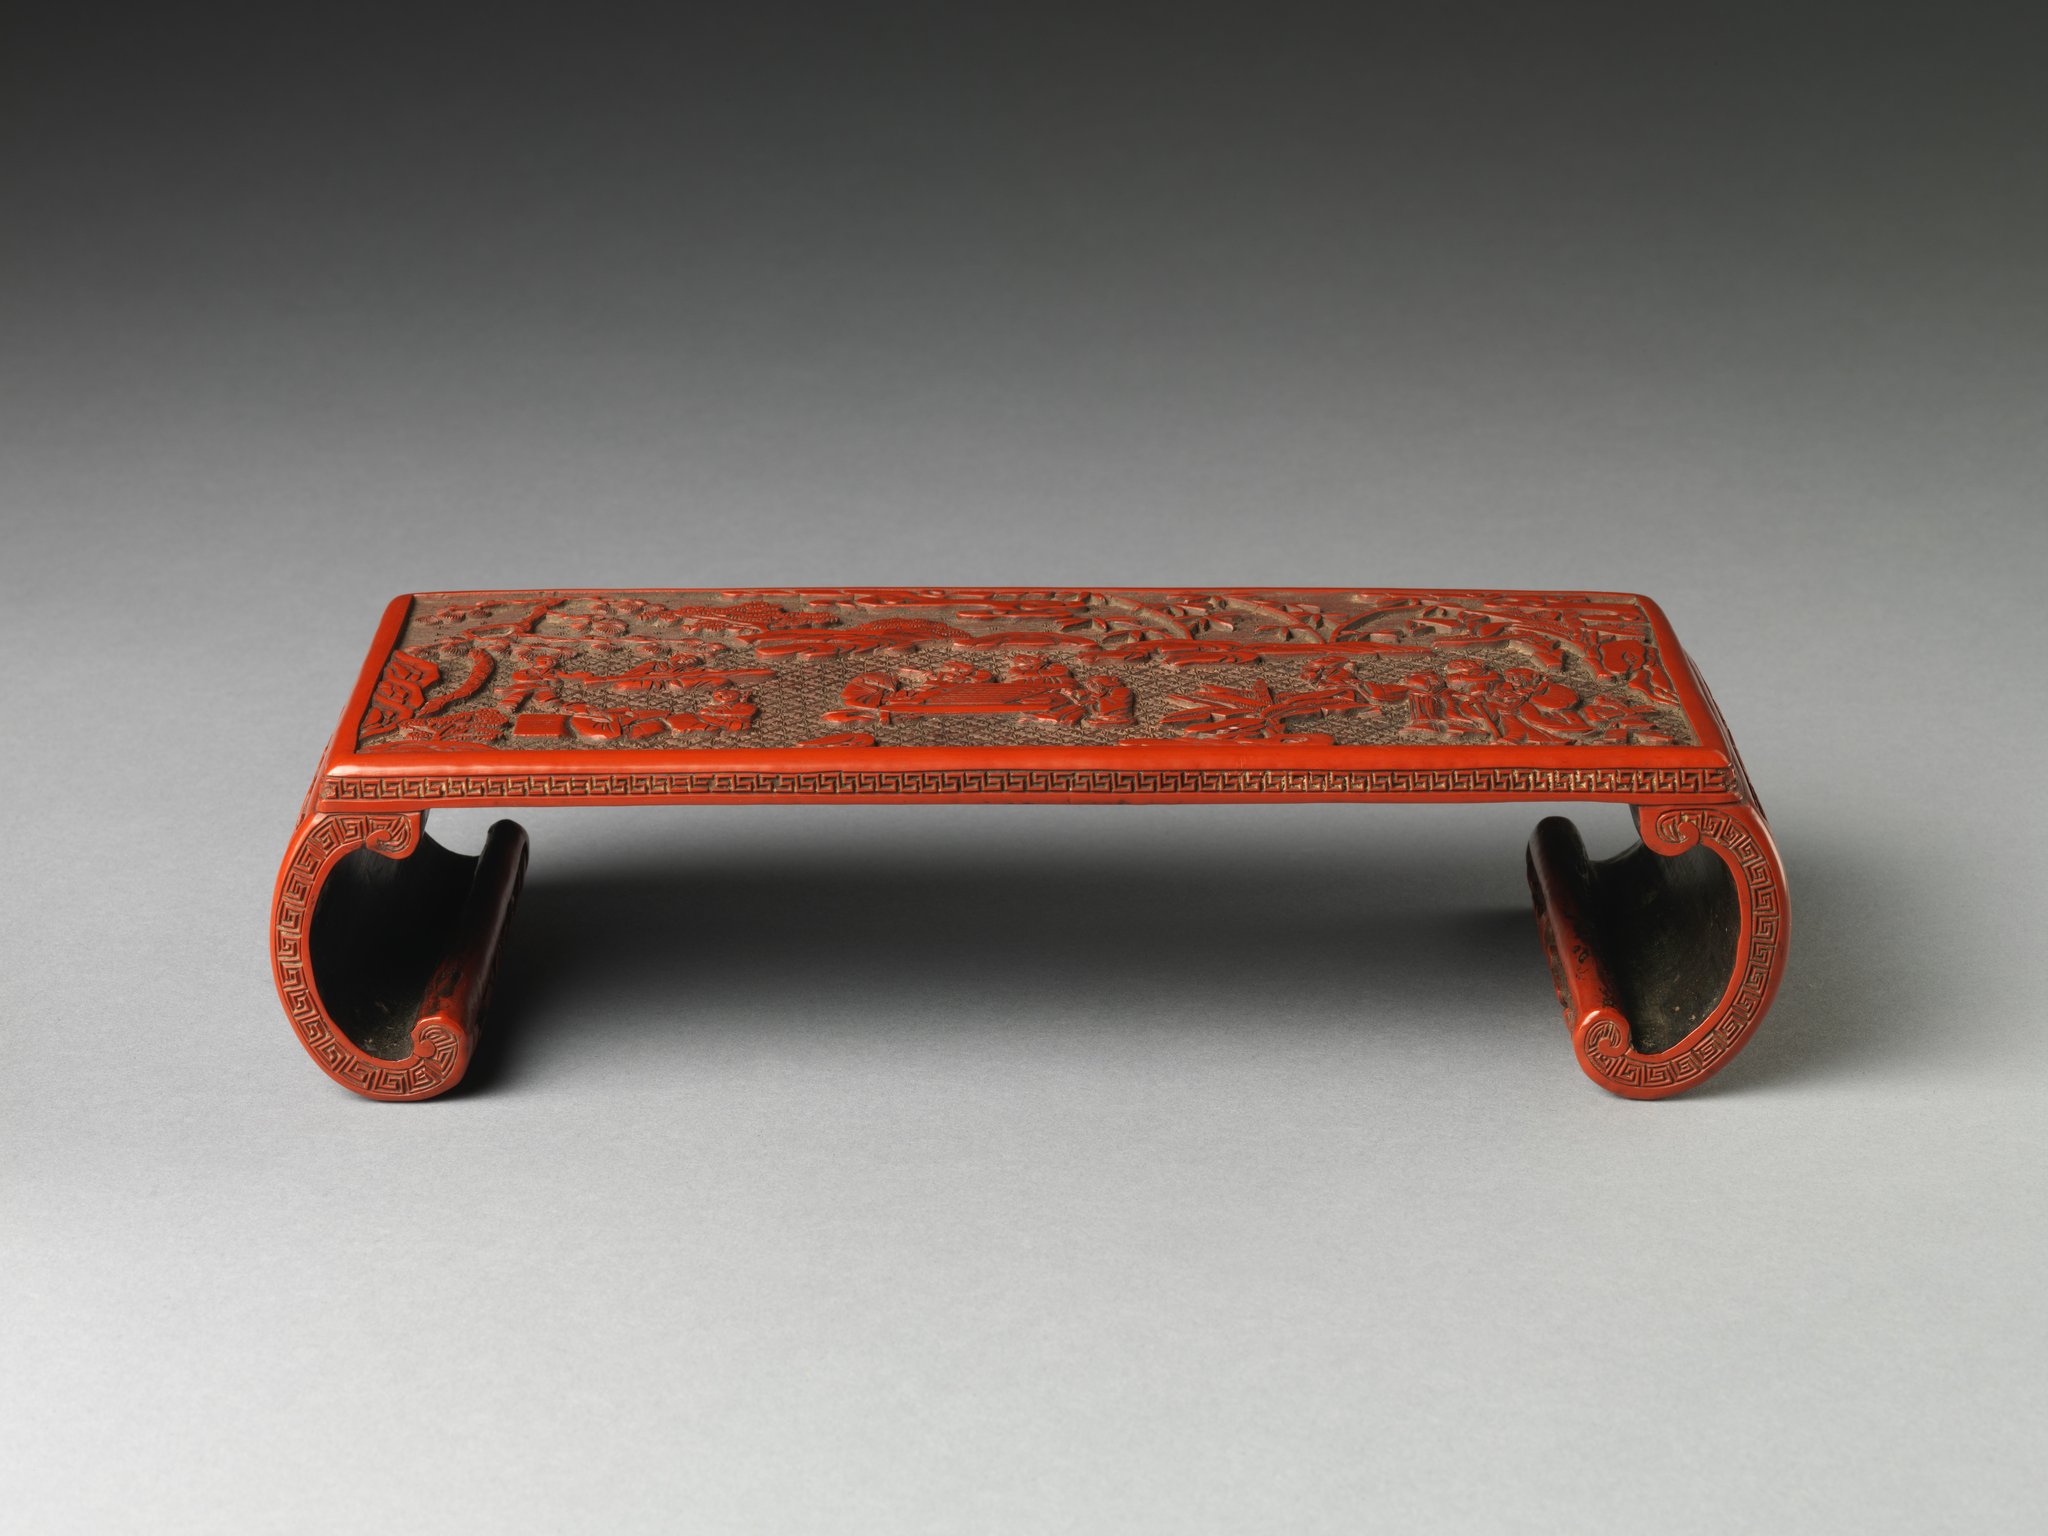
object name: table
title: Small table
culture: chinese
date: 1368-1644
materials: lacquer